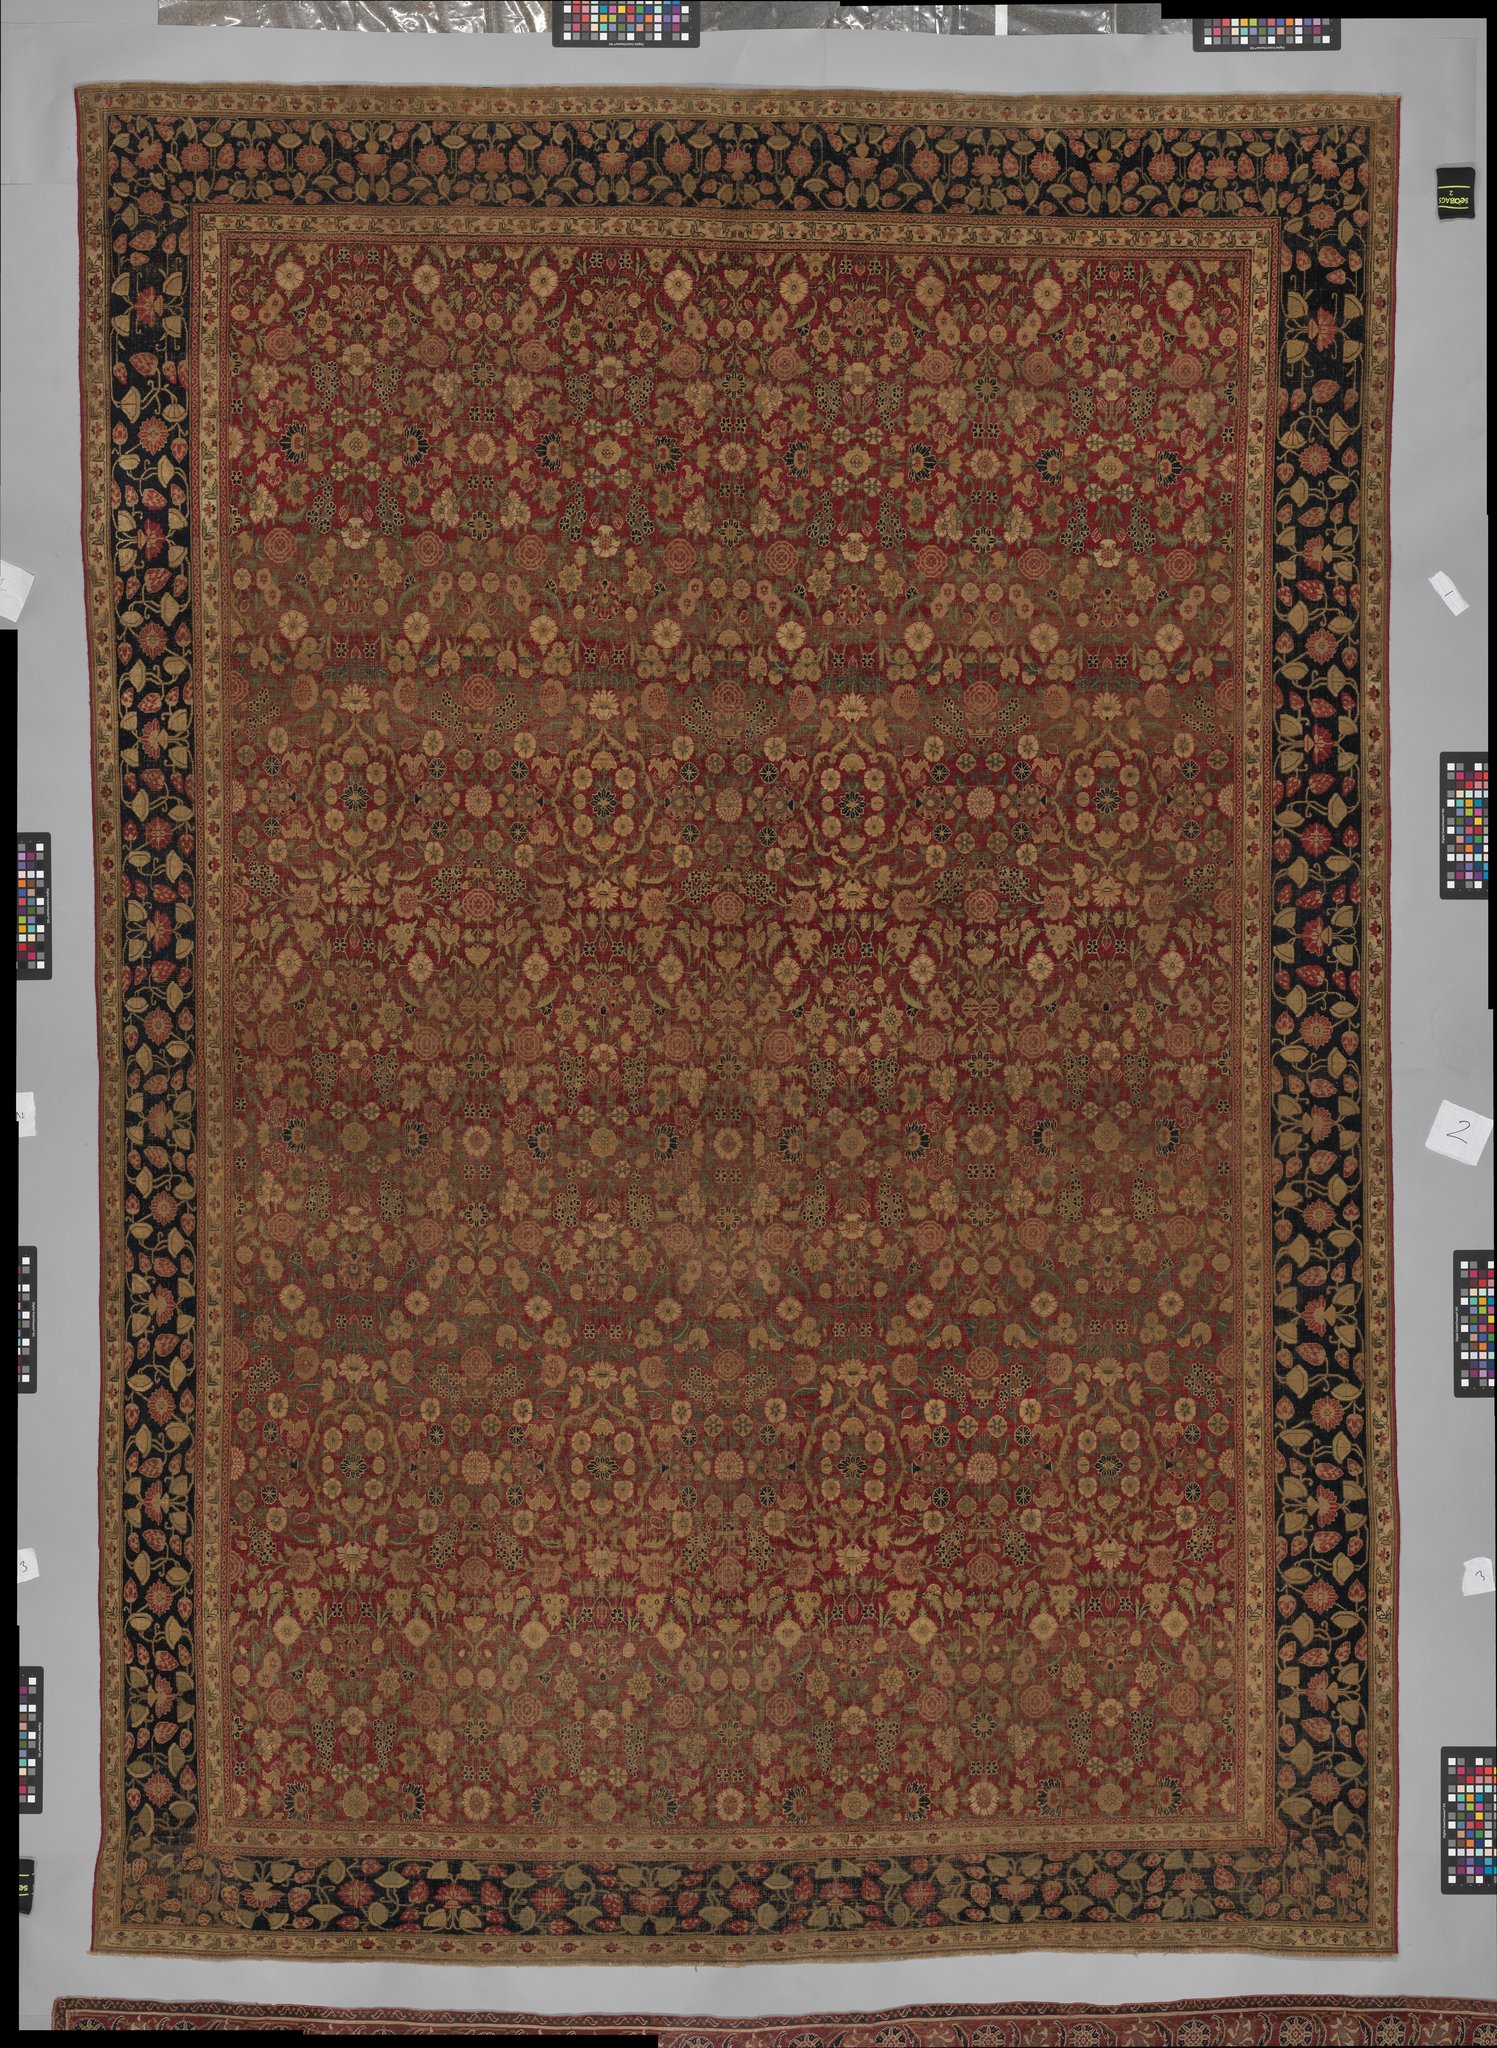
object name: carpet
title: "Millefleur" Carpet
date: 1701-1800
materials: cotton, wool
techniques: asymmetrically knotted pile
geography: india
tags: flowers